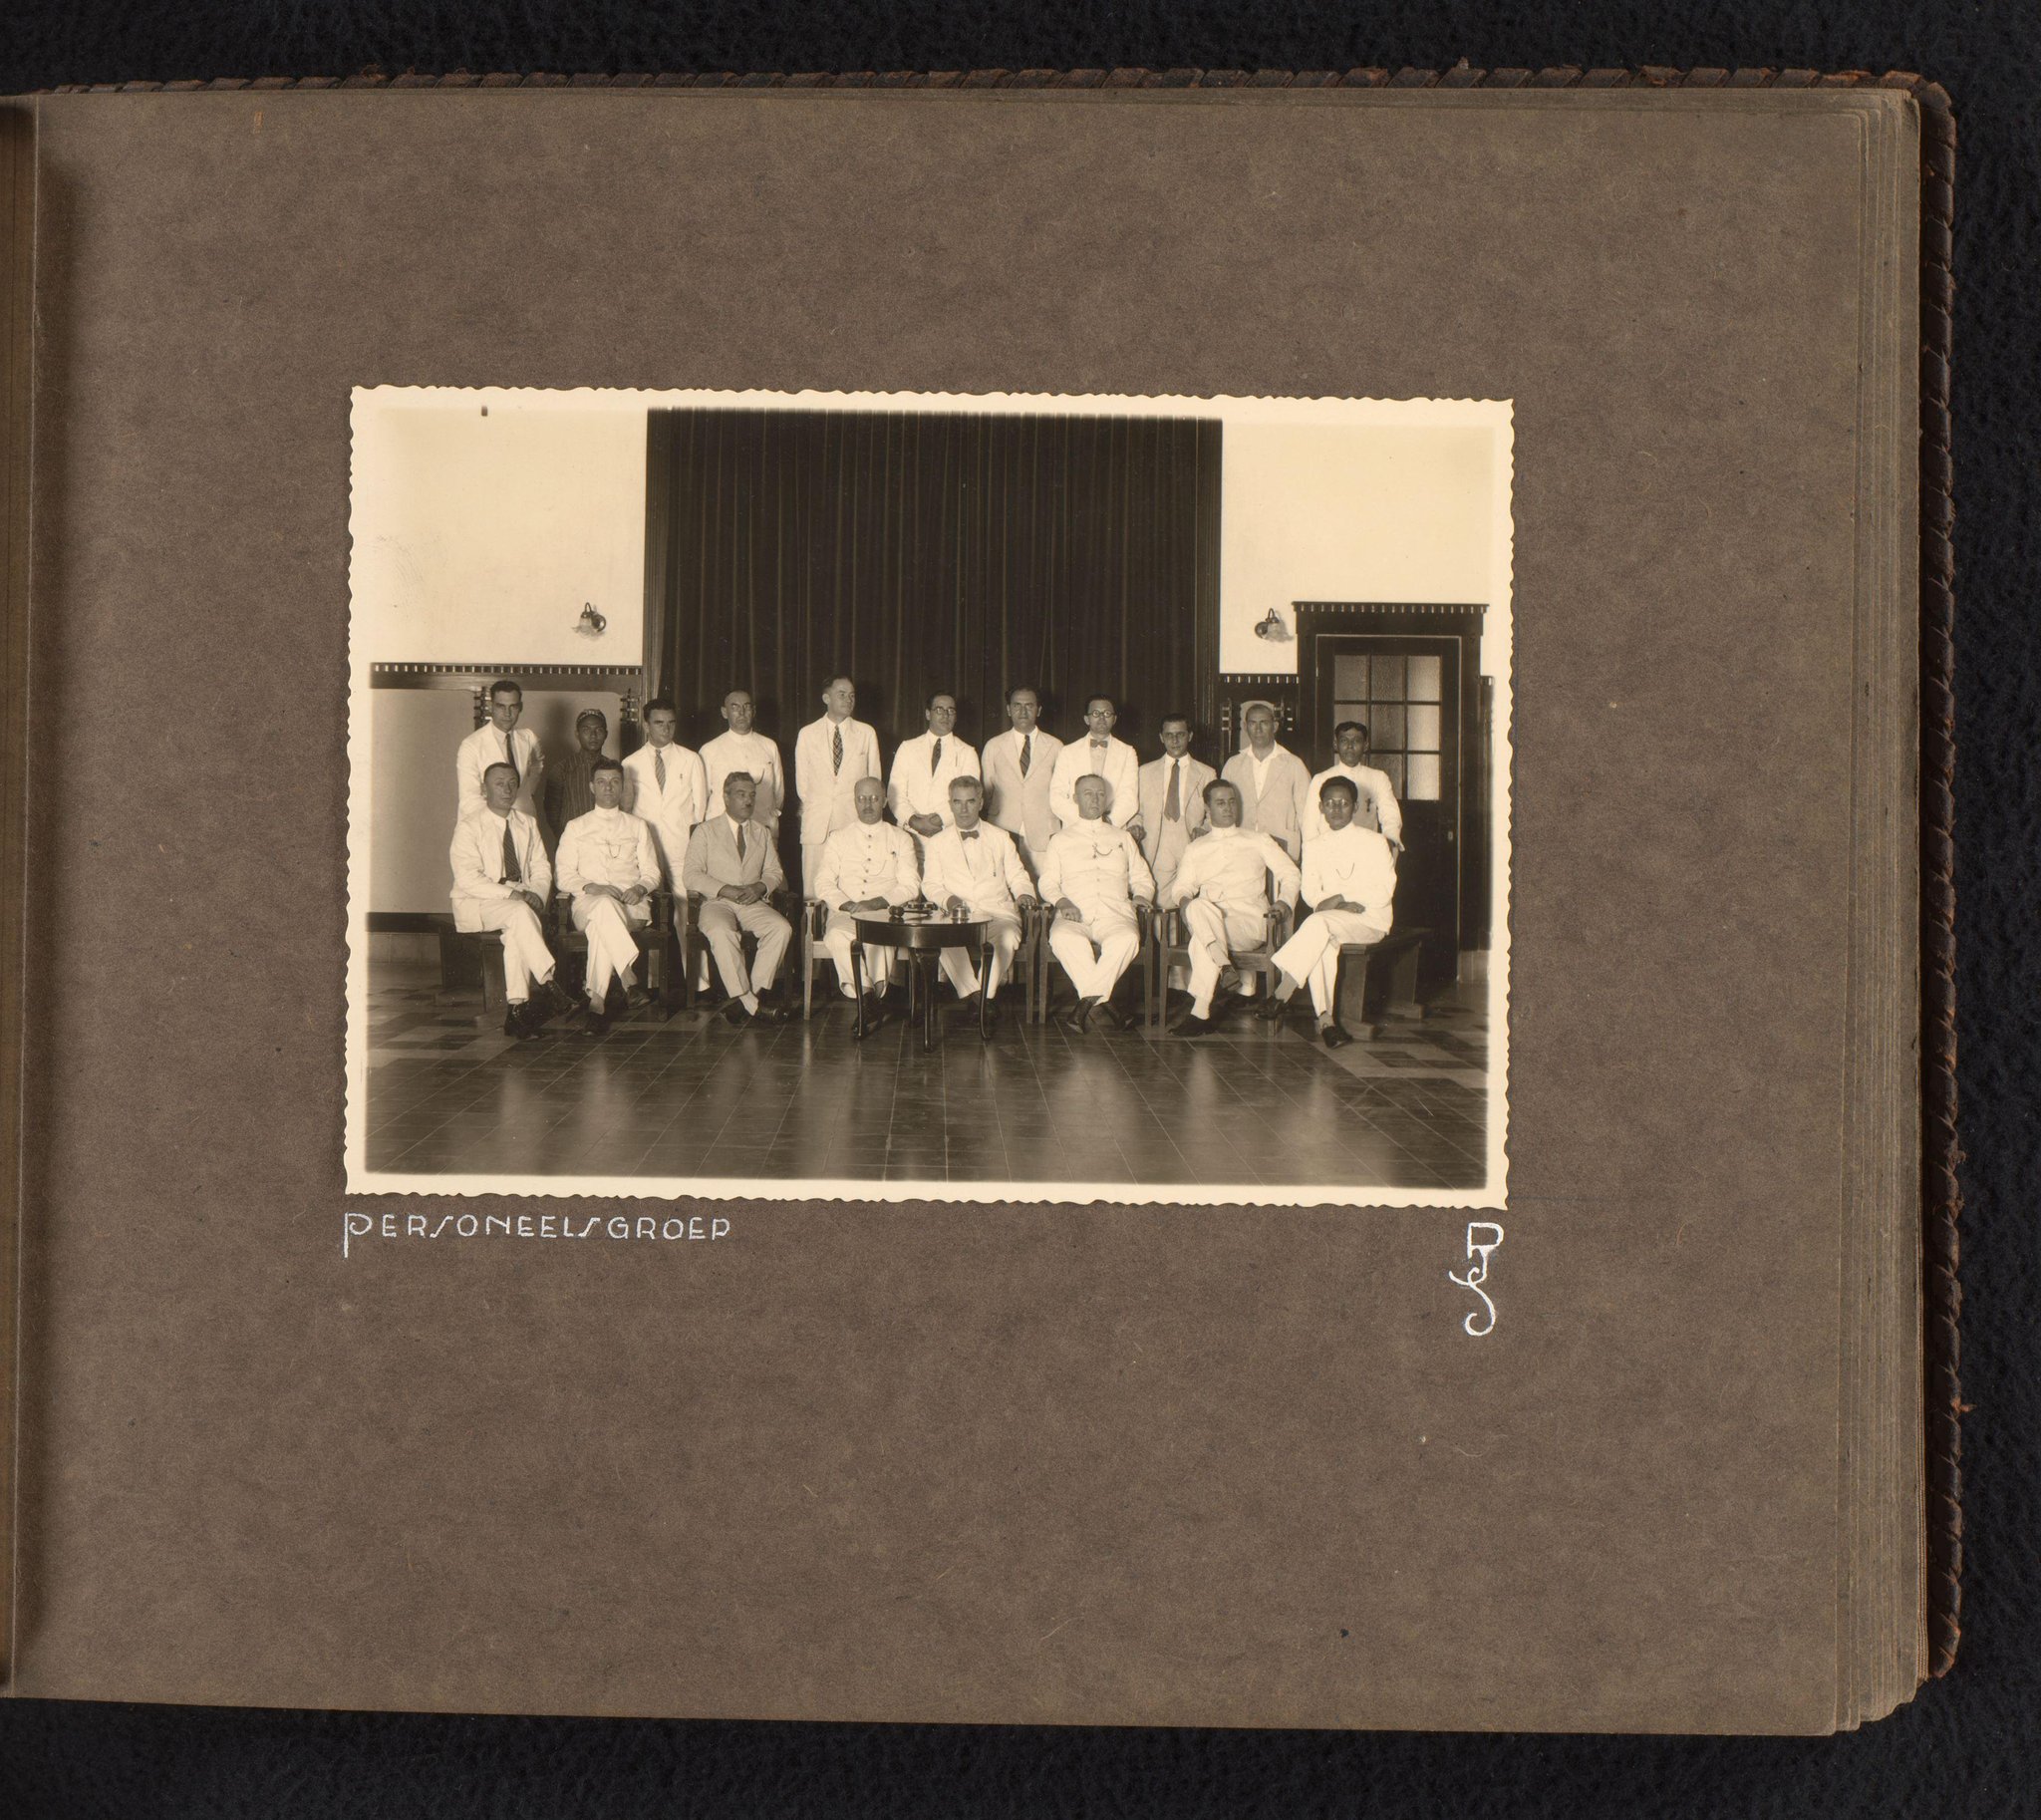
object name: photograph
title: Personeel van de Prinses Juliana School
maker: Anonymous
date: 1933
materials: photographic support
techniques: gelatin silver print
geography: jogjakarta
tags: vocational education, e.g.: junior technical school, colonial government, anonymous historical persons portrayed in a group, in a group-portrait, dutch east indies, the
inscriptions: inscription: ‘Personeelsgroep / PJS’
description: Groepsfoto van het personeel van de Prinses Juliana School te Jogyakarta. Groep mannen poserend in twee rijen in de school. Foto ingeplakt in het fotoalbum aangeboden aan J.H.A. van der Hoeven bij het beëindigen op 31 juli 1933 van zijn diensttijd bij het Nijverheidsonderwijs in Nederlandsch-Indië.